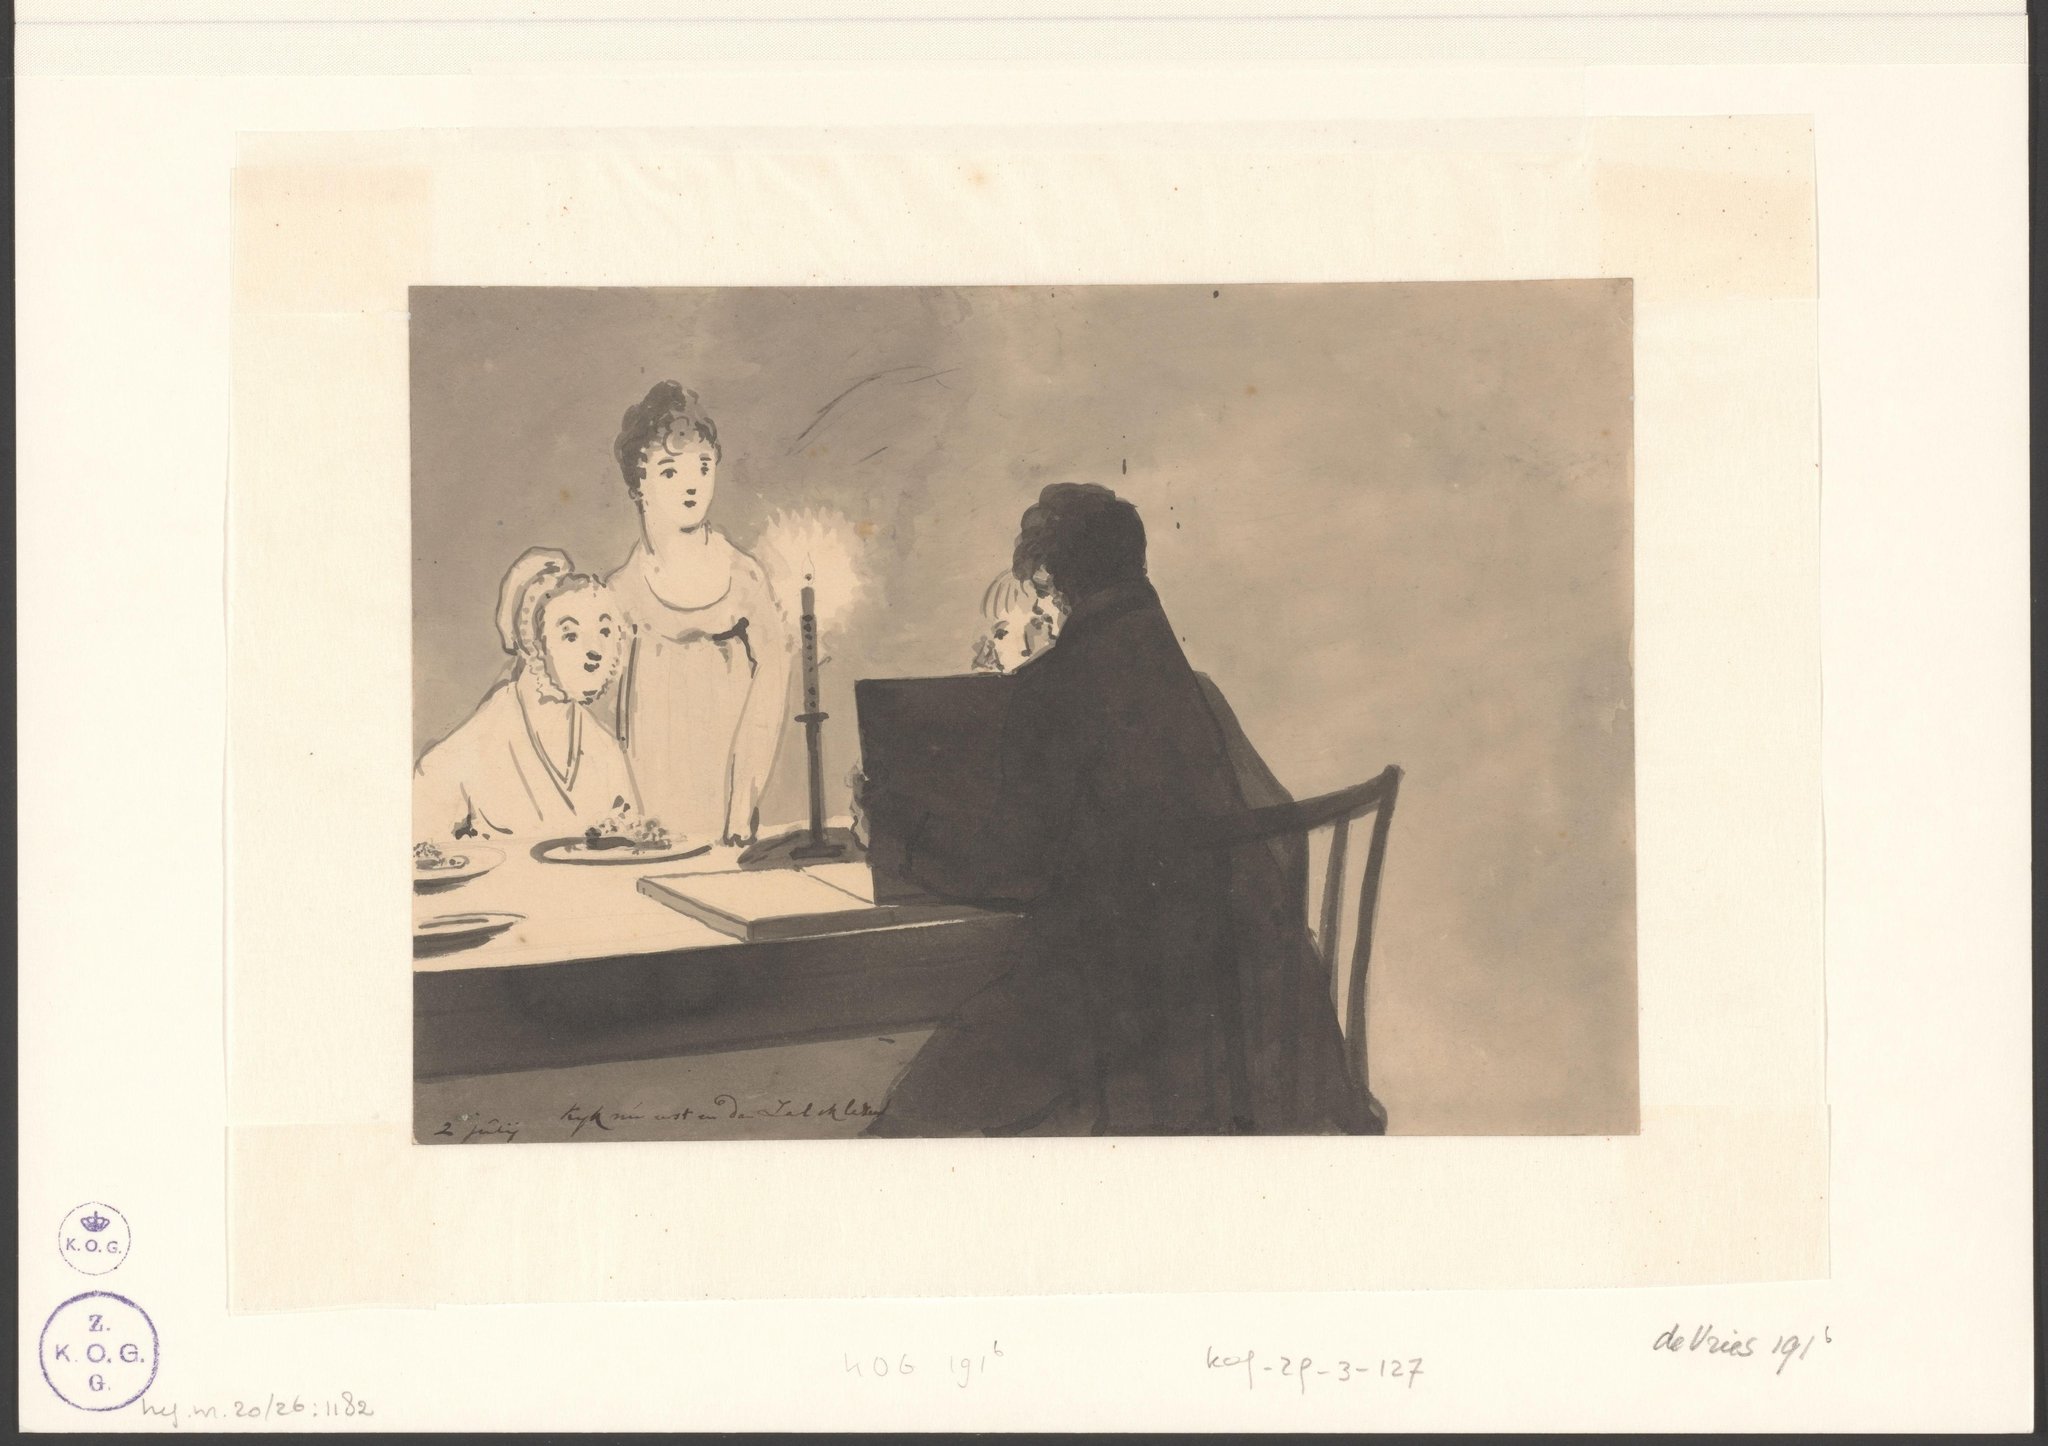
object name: print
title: Christiaan Andriessen toont zijn getekende dagboek aan zijn familie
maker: christiaan andriessen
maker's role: draughtsman, print maker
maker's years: 1775-1846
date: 1806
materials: ink, paper, pencil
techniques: brush, pen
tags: amsterdam, print maker, draughtsman, christiaan andriessen, book, candle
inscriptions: inscription: ‘2 julij Kijk nu eerst en dan zal ik lezen’, signature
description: Christiaan Andriessen toont een dagboekblad aan zijn familie. Mogelijk gaat het om het blad van 30 juni, dat een lang onderschrift in geheimschrift heeft.